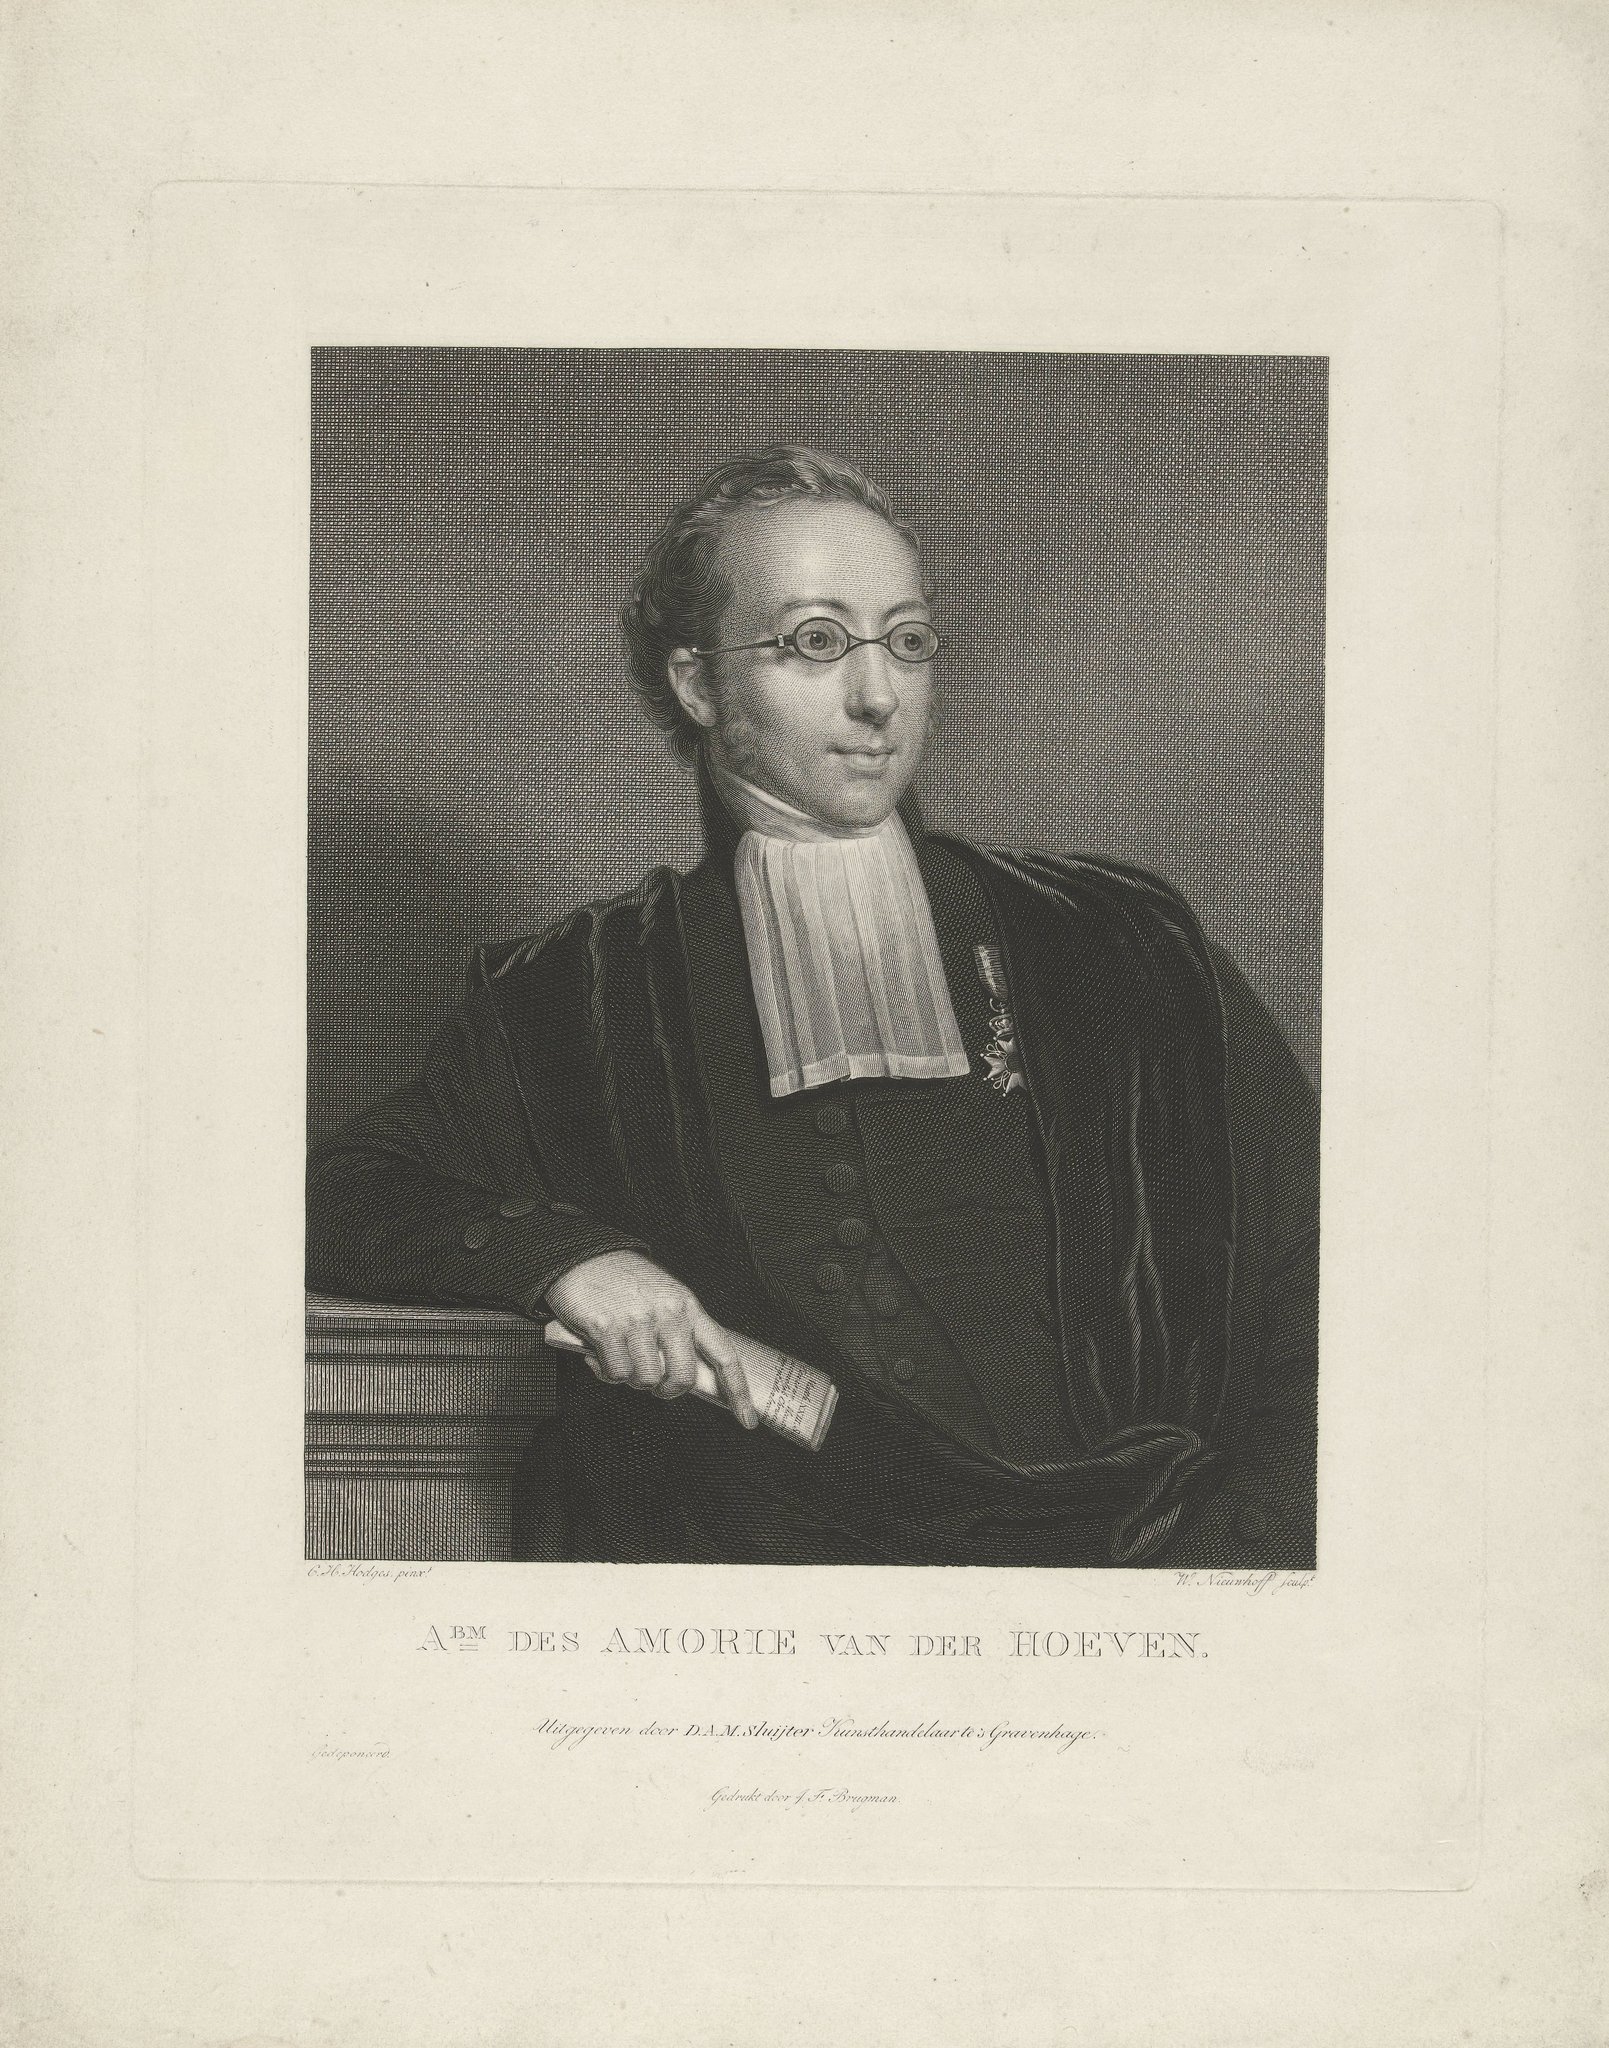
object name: print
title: Portret van Abraham des Amorie van der Hoeven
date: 1835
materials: paper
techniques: engraving, etching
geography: the hague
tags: rotterdam, arnhem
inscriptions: collector's mark: Lugt 2228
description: Portret van Abraham des Amorie van der Hoeven, predikant en hoogleraar van de Remonstrantse Broederschap. Van der Hoeven is gekleed in een zwarte jas met stola en witte bef. In zijn hand houdt hij een papier met een Bijbeltekst. Portret ten halven lijve naar rechts.